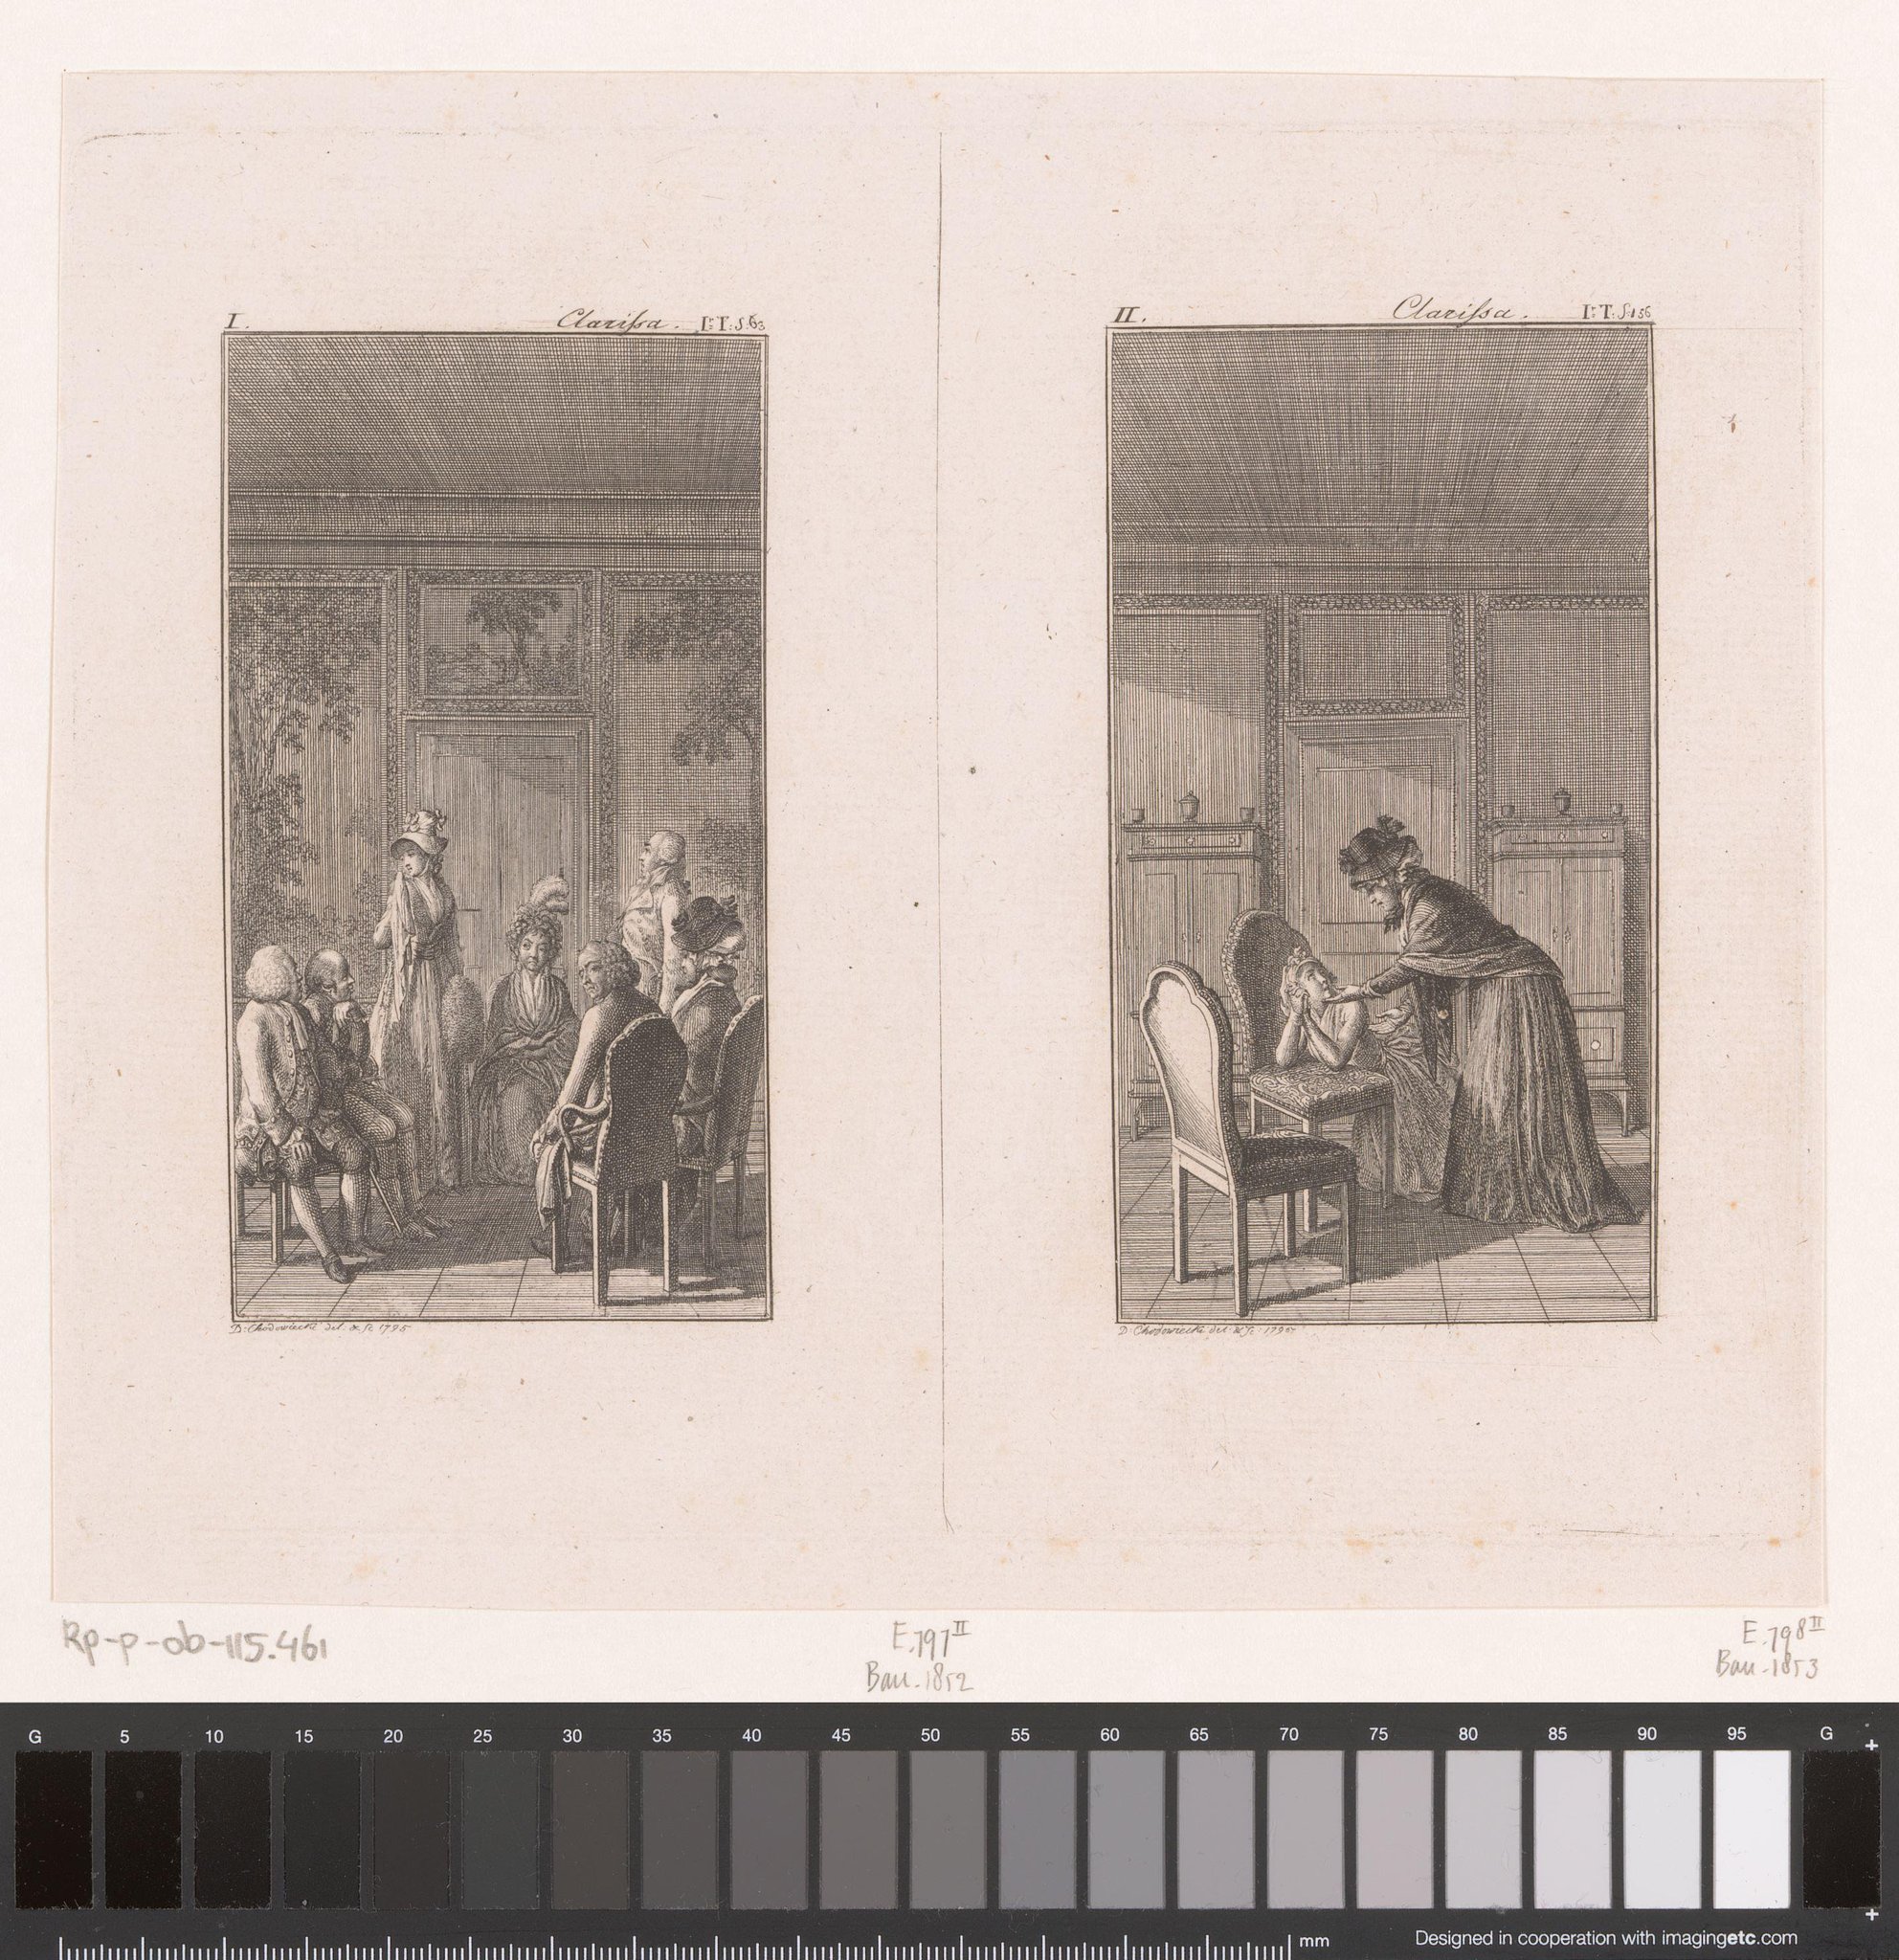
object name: print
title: Twee voorstellingen uit Clarissa van Samuel Richardson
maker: daniel nikolaus chodowiecki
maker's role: draughtsman, print maker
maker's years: 1726-1801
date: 1795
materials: paper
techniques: etching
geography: berlin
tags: adolescent, young woman, maiden, literature, weeping, one person praying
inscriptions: collector's mark: Lugt 2228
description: Prenten gebruikt voor: Richardson, Samuel. Clarissens Schicksale dargestellt in vier und zwanzig Kupferblättern von Daniel Chodowiecki. mit Erläuterungen des Deutschen Uebersetzers Dr. L. Th. Kosegarten. Leipzig: Heinrich Gräff, 1796.